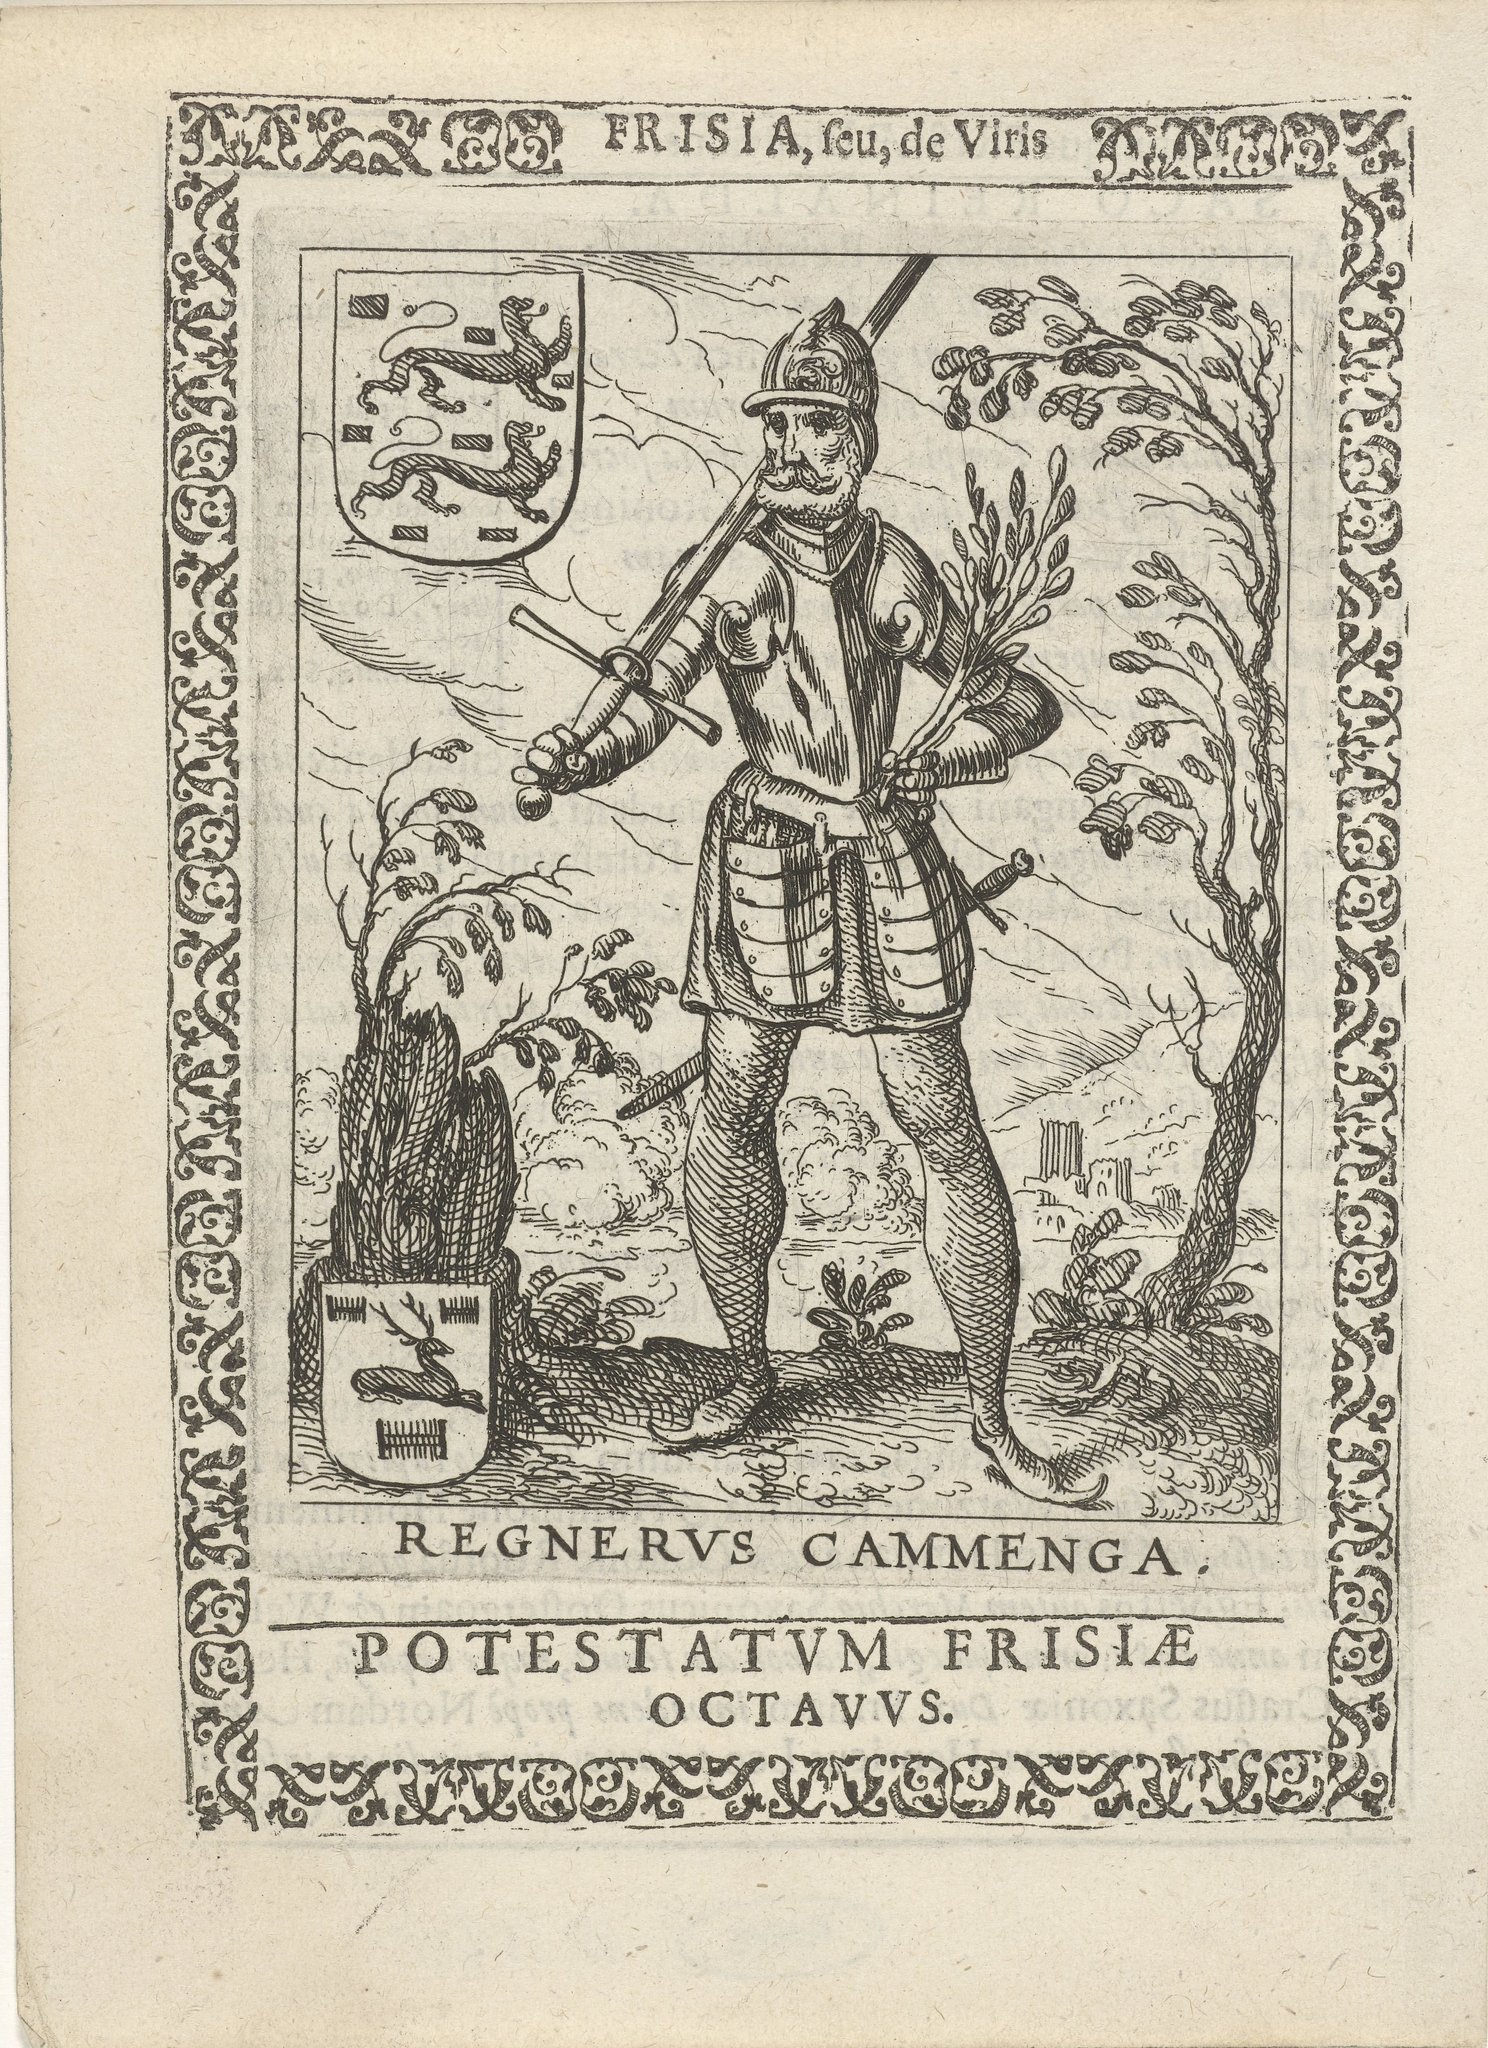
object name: book illustration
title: Koningen en Potestaten van Friesland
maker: pieter feddes van harlingen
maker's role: painter, print maker, publisher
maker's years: 1586-1623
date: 1618-1620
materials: paper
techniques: etching, letterpress printing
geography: friesland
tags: ruler, sovereign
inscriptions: collector's mark: Lugt 2228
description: Reinier Camminga, achtste potestaat van Friesland. Staande ten voeten uit, zwaard over de schouder, tak in de hand. Illustratie, met tekst op achterzijde, afkomstig uit het boek: Frisia seu de viris rebusque Frisiae illustribus libri duo.